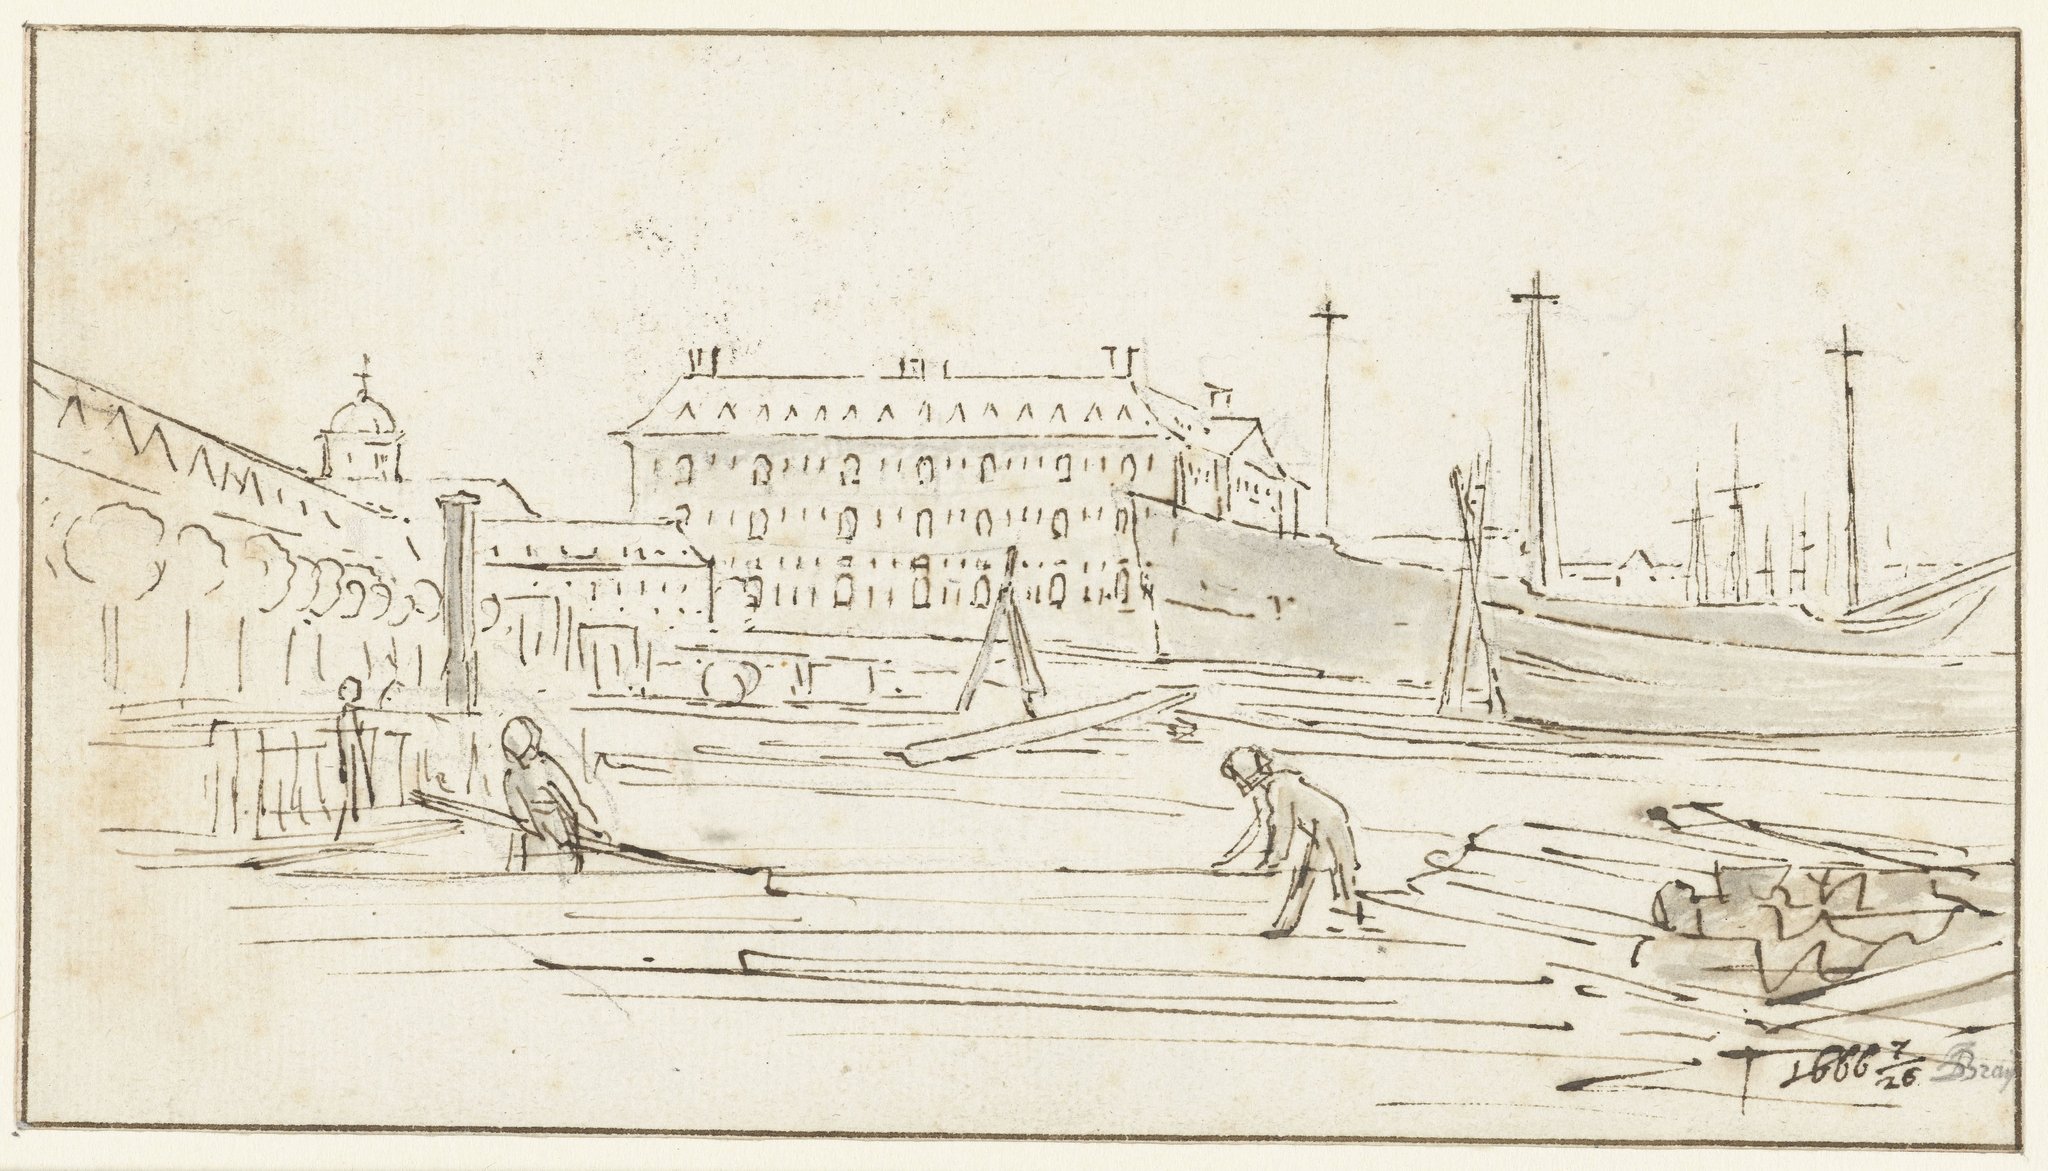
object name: drawing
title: View of the National Sea Arsenal from the North, and a Shipyard in Amsterdam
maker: jan de bray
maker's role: draughtsman, print maker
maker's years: 1627-1697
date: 1666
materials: ink, paper, pencil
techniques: brush, pen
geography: amsterdam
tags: 's lands zeemagazijn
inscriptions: date: ‘1666 7/26’